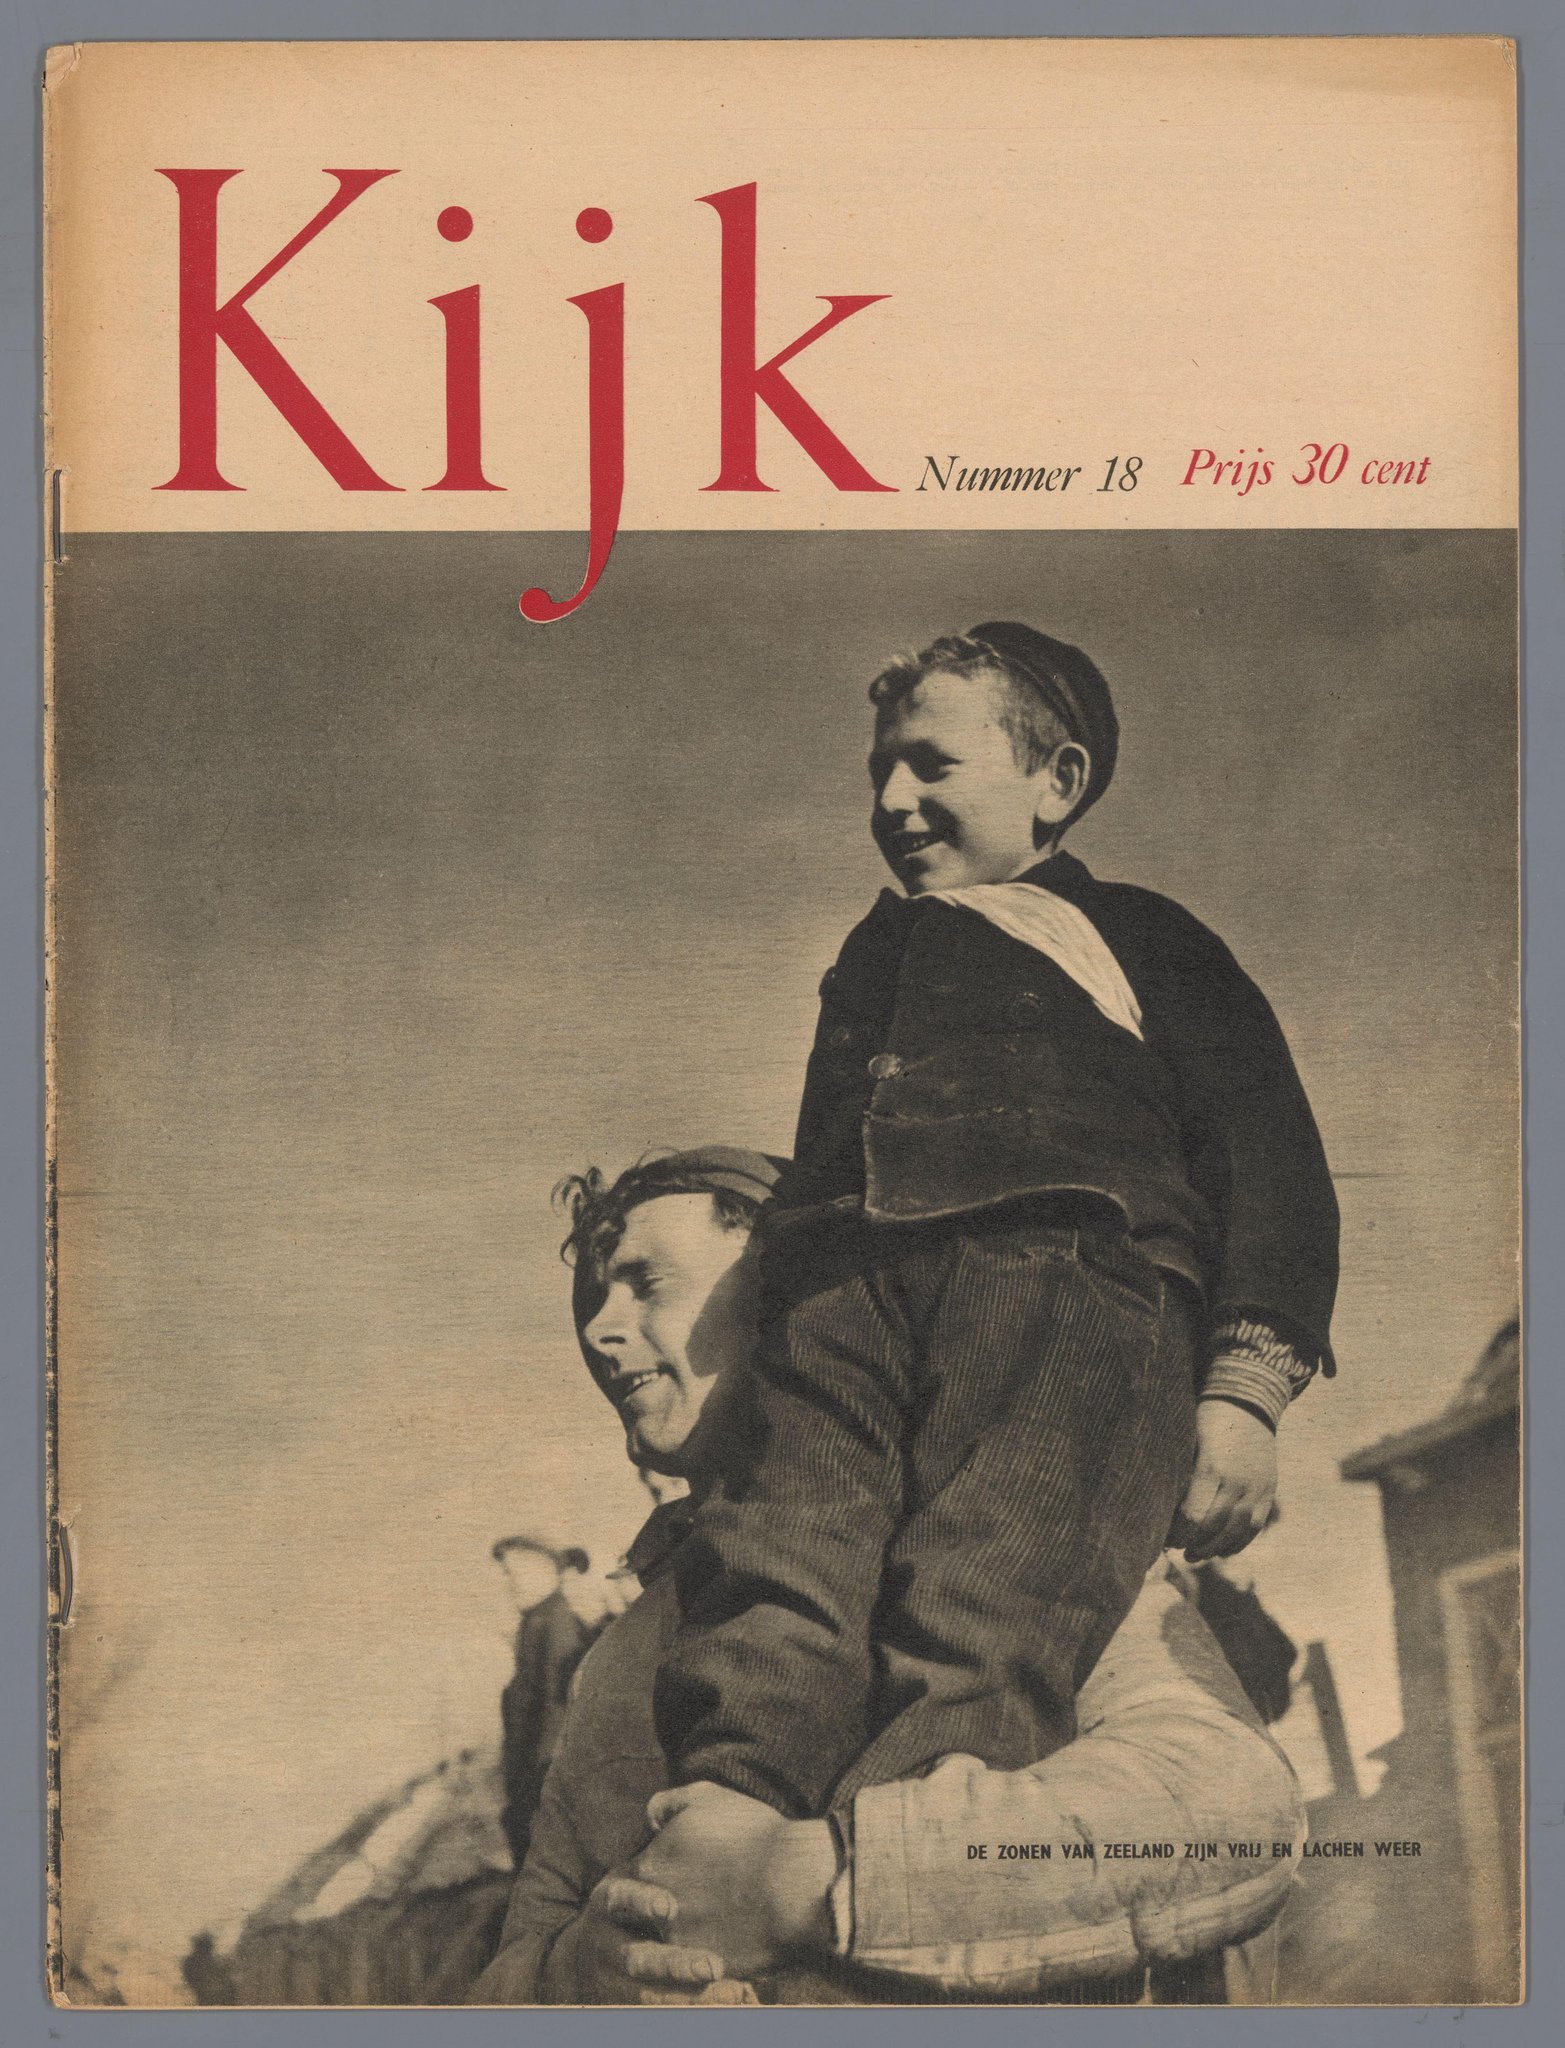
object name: magazine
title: 'Kijk', exemplaar nr. 18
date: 1945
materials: paper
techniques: printing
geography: london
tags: tweede wereldoorlog, bevrijding van nederland (1945)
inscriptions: title: ‘Kijk’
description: "Kijk wordt om de veertien dagen uitgegeven door de Amerikaanschen Voorlichingsdienst om eht wereldnieuws te geven in woord en beeld, totdat uw eigen pers deze taak kan overnemen." Omschrijving van het blad Kijk, overgenomen uit dit blad.